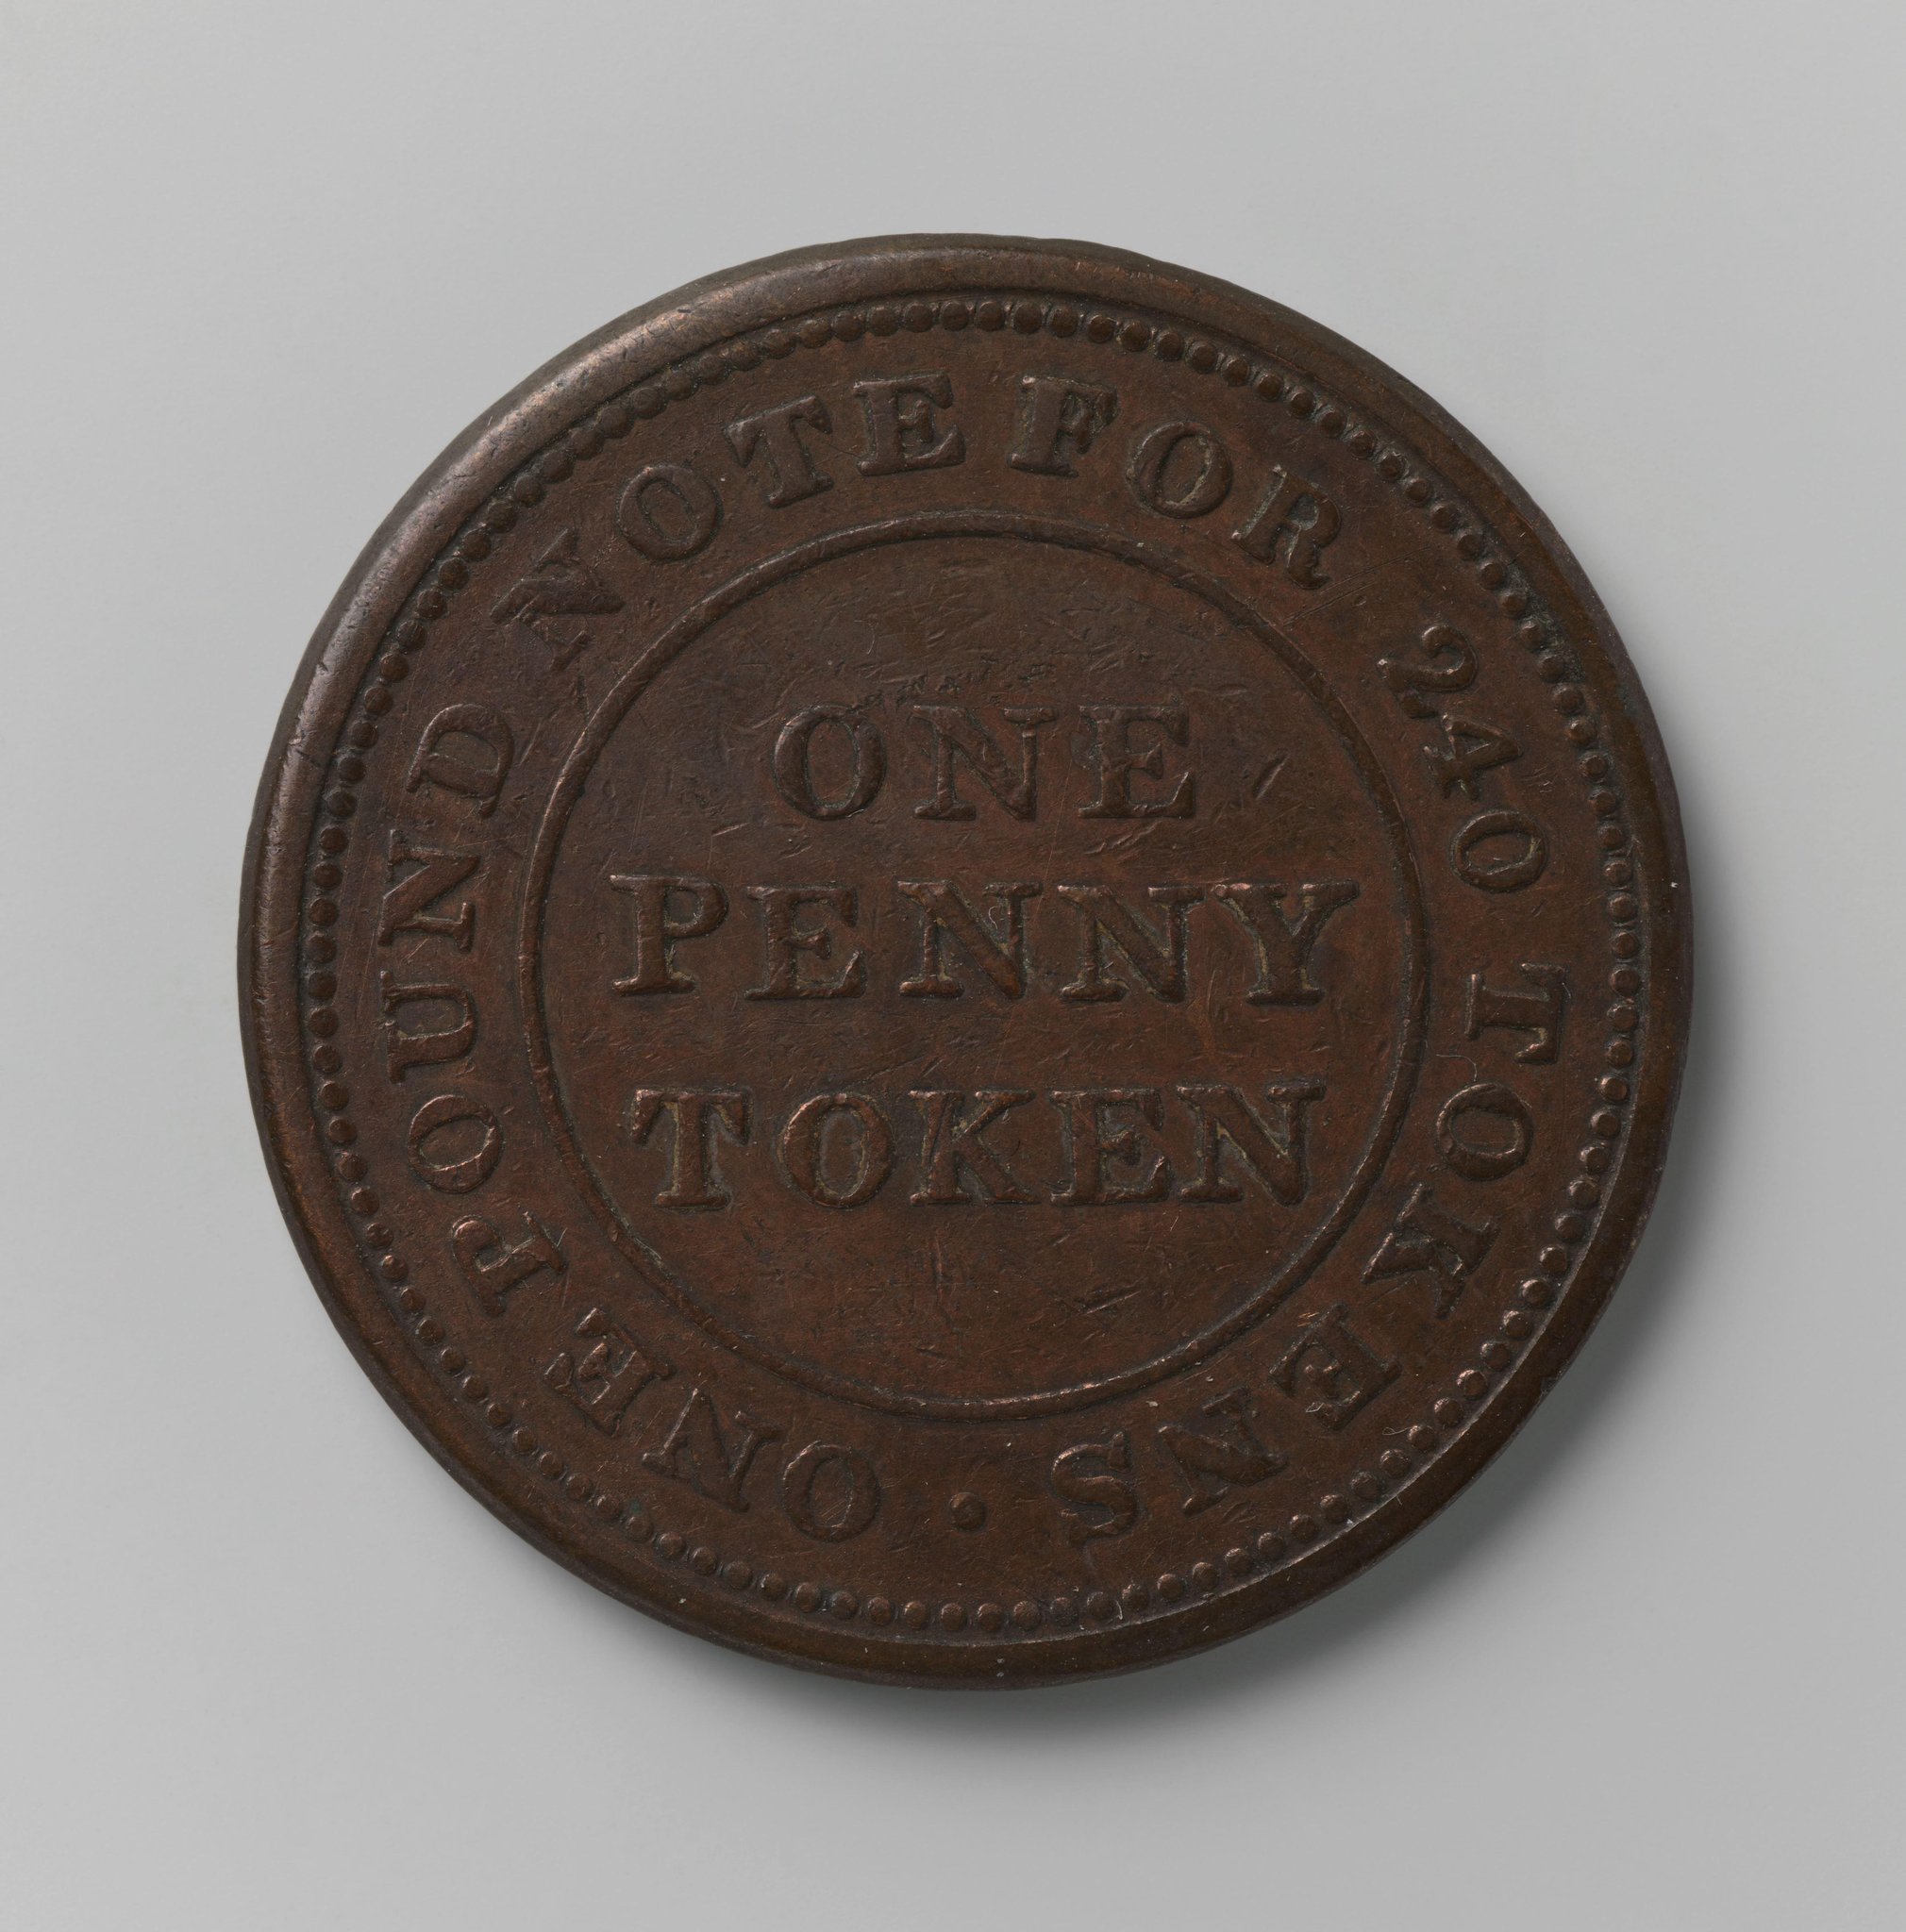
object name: monetary token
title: betaalpenning (token) voor een penny van Flint, Wales, 1813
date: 1813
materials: copper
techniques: striking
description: Koperen particuliere munt. Voorzijde: fabriekscomplex in bedrijf. Jaartal onderaan.Keerzijde: waarde-aanduiding in drie regels. Kabelrand.